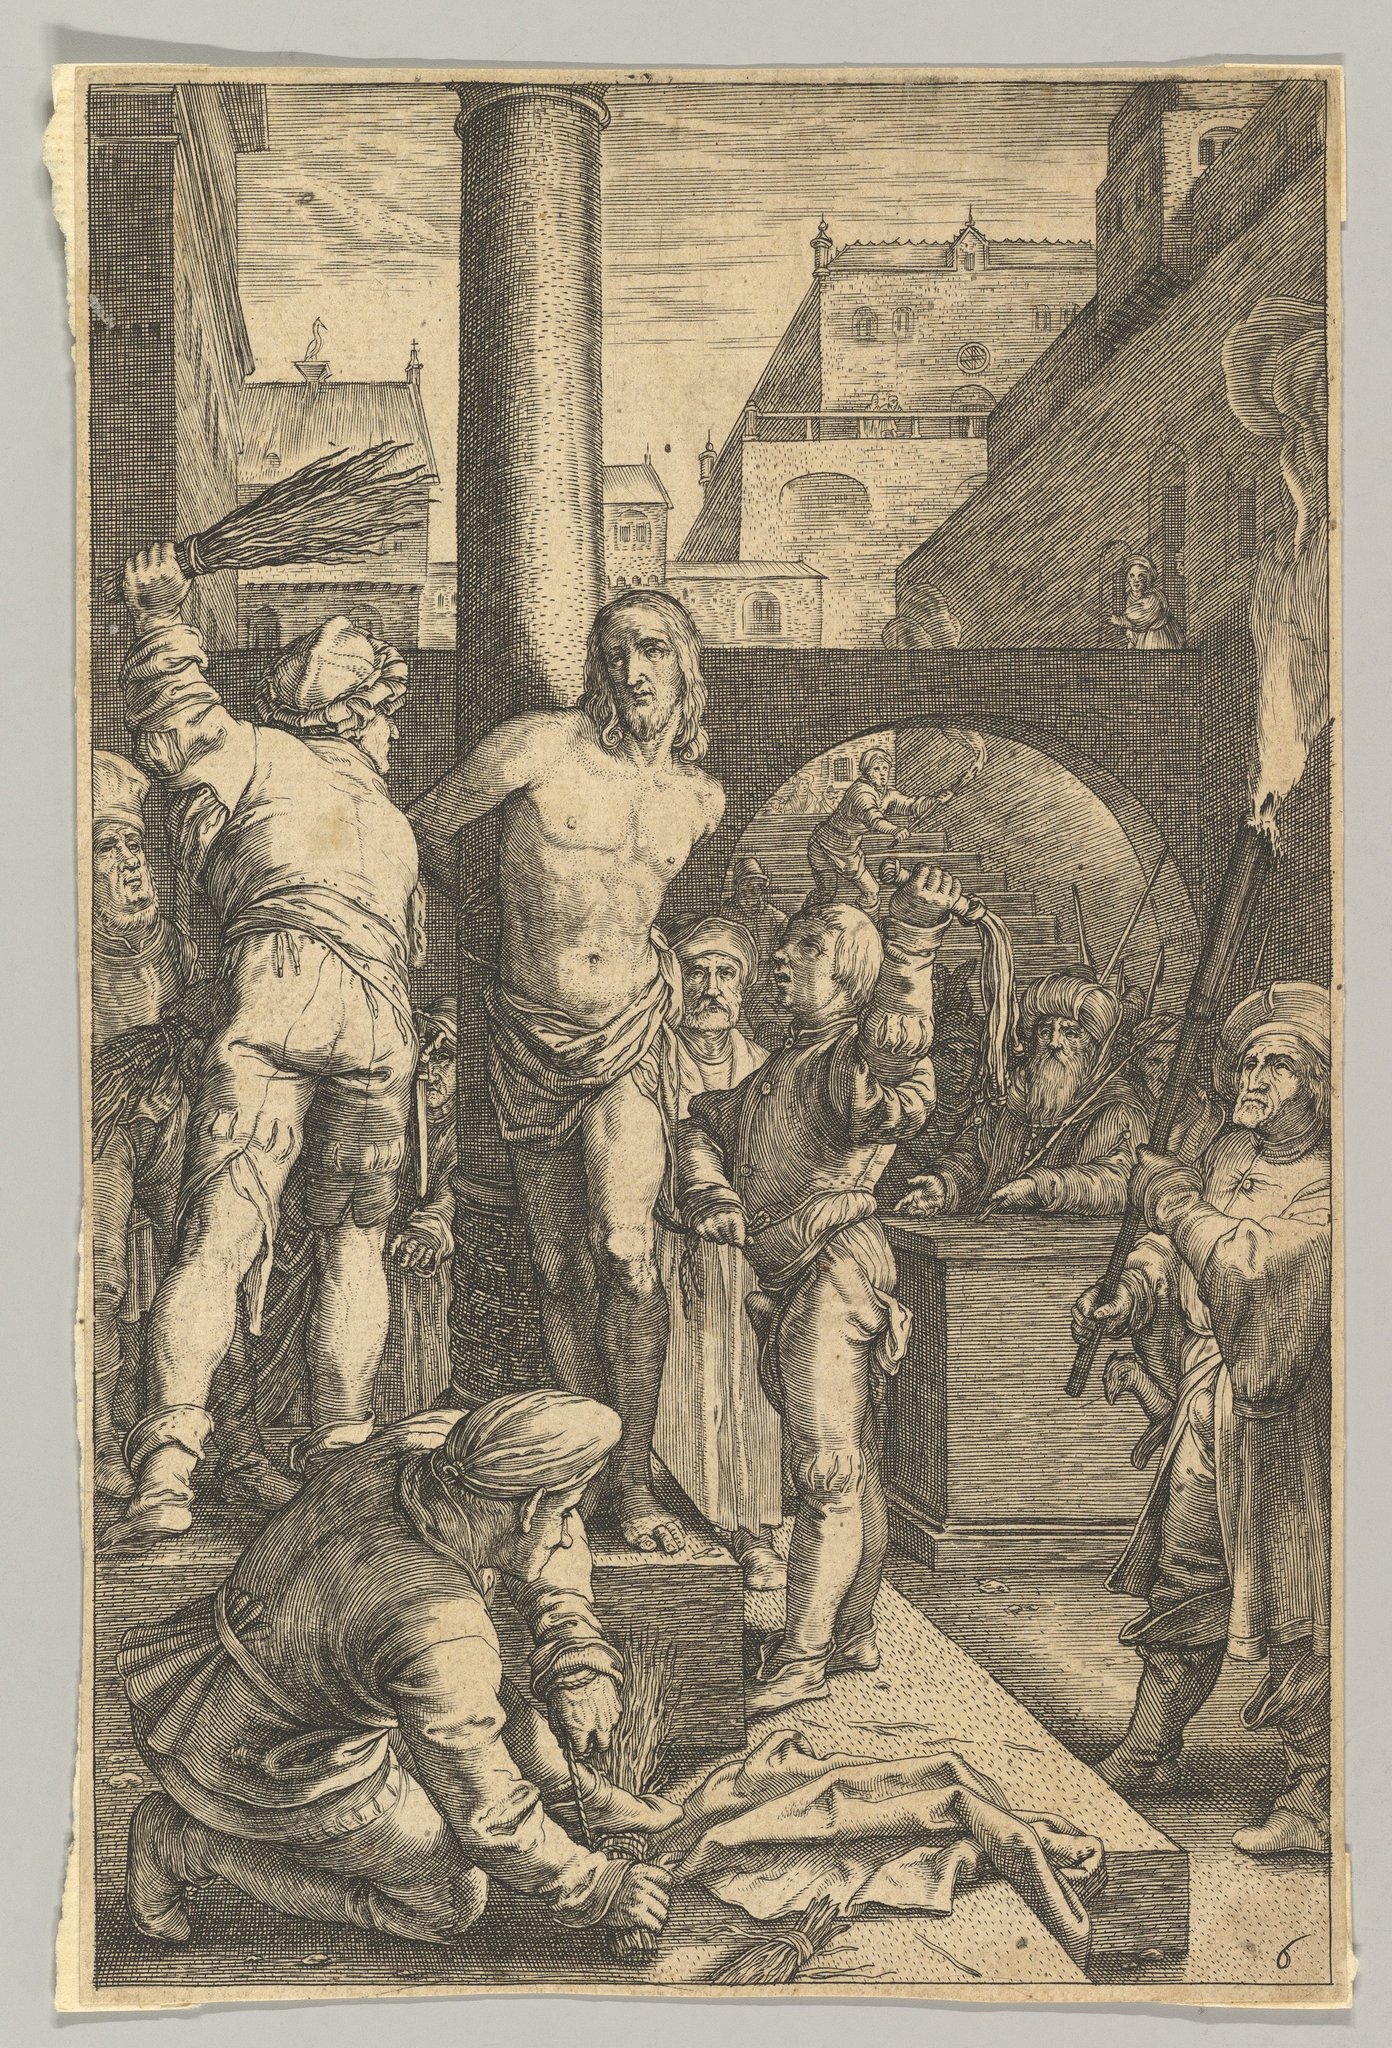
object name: print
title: The Flagellation, from "The Passion of Christ"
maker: ludovicus siceram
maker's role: artist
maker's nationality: flemish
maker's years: 1618-1628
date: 1623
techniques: engraving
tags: men,christ